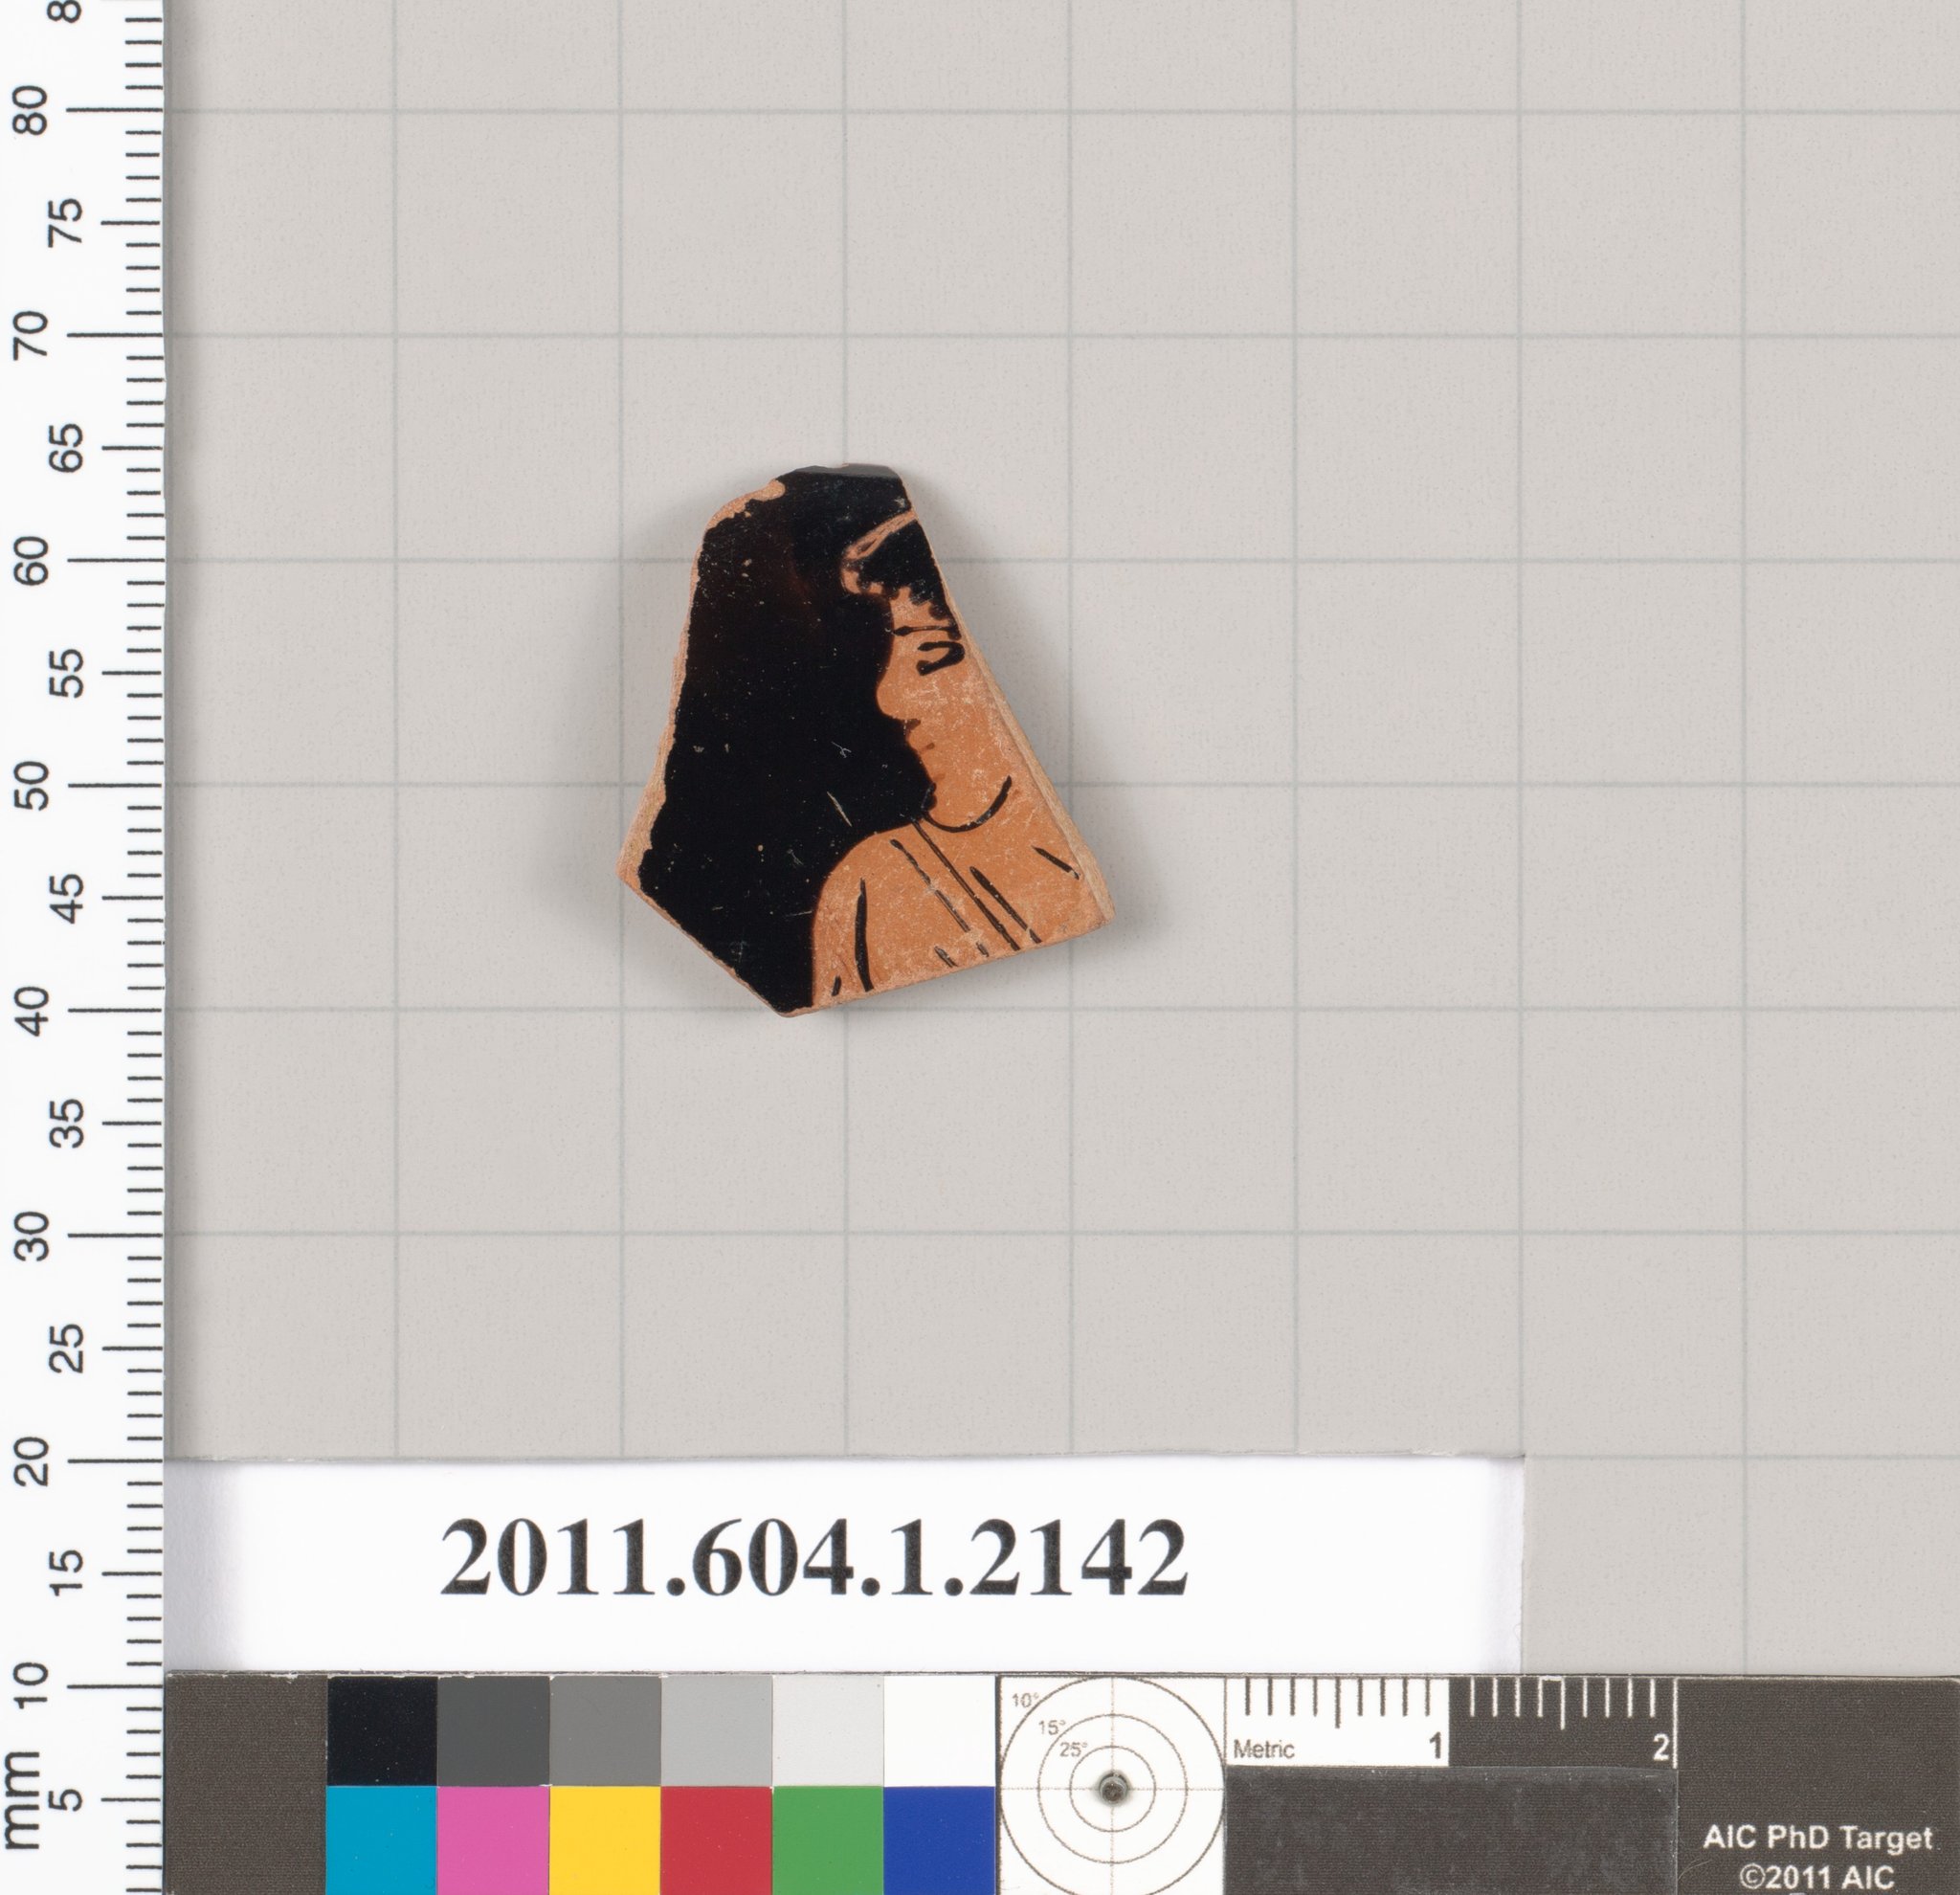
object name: kylix fragment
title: Terracotta rim fragment of a kylix (drinking cup)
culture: greek, attic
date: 467-435 BCE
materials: terracotta